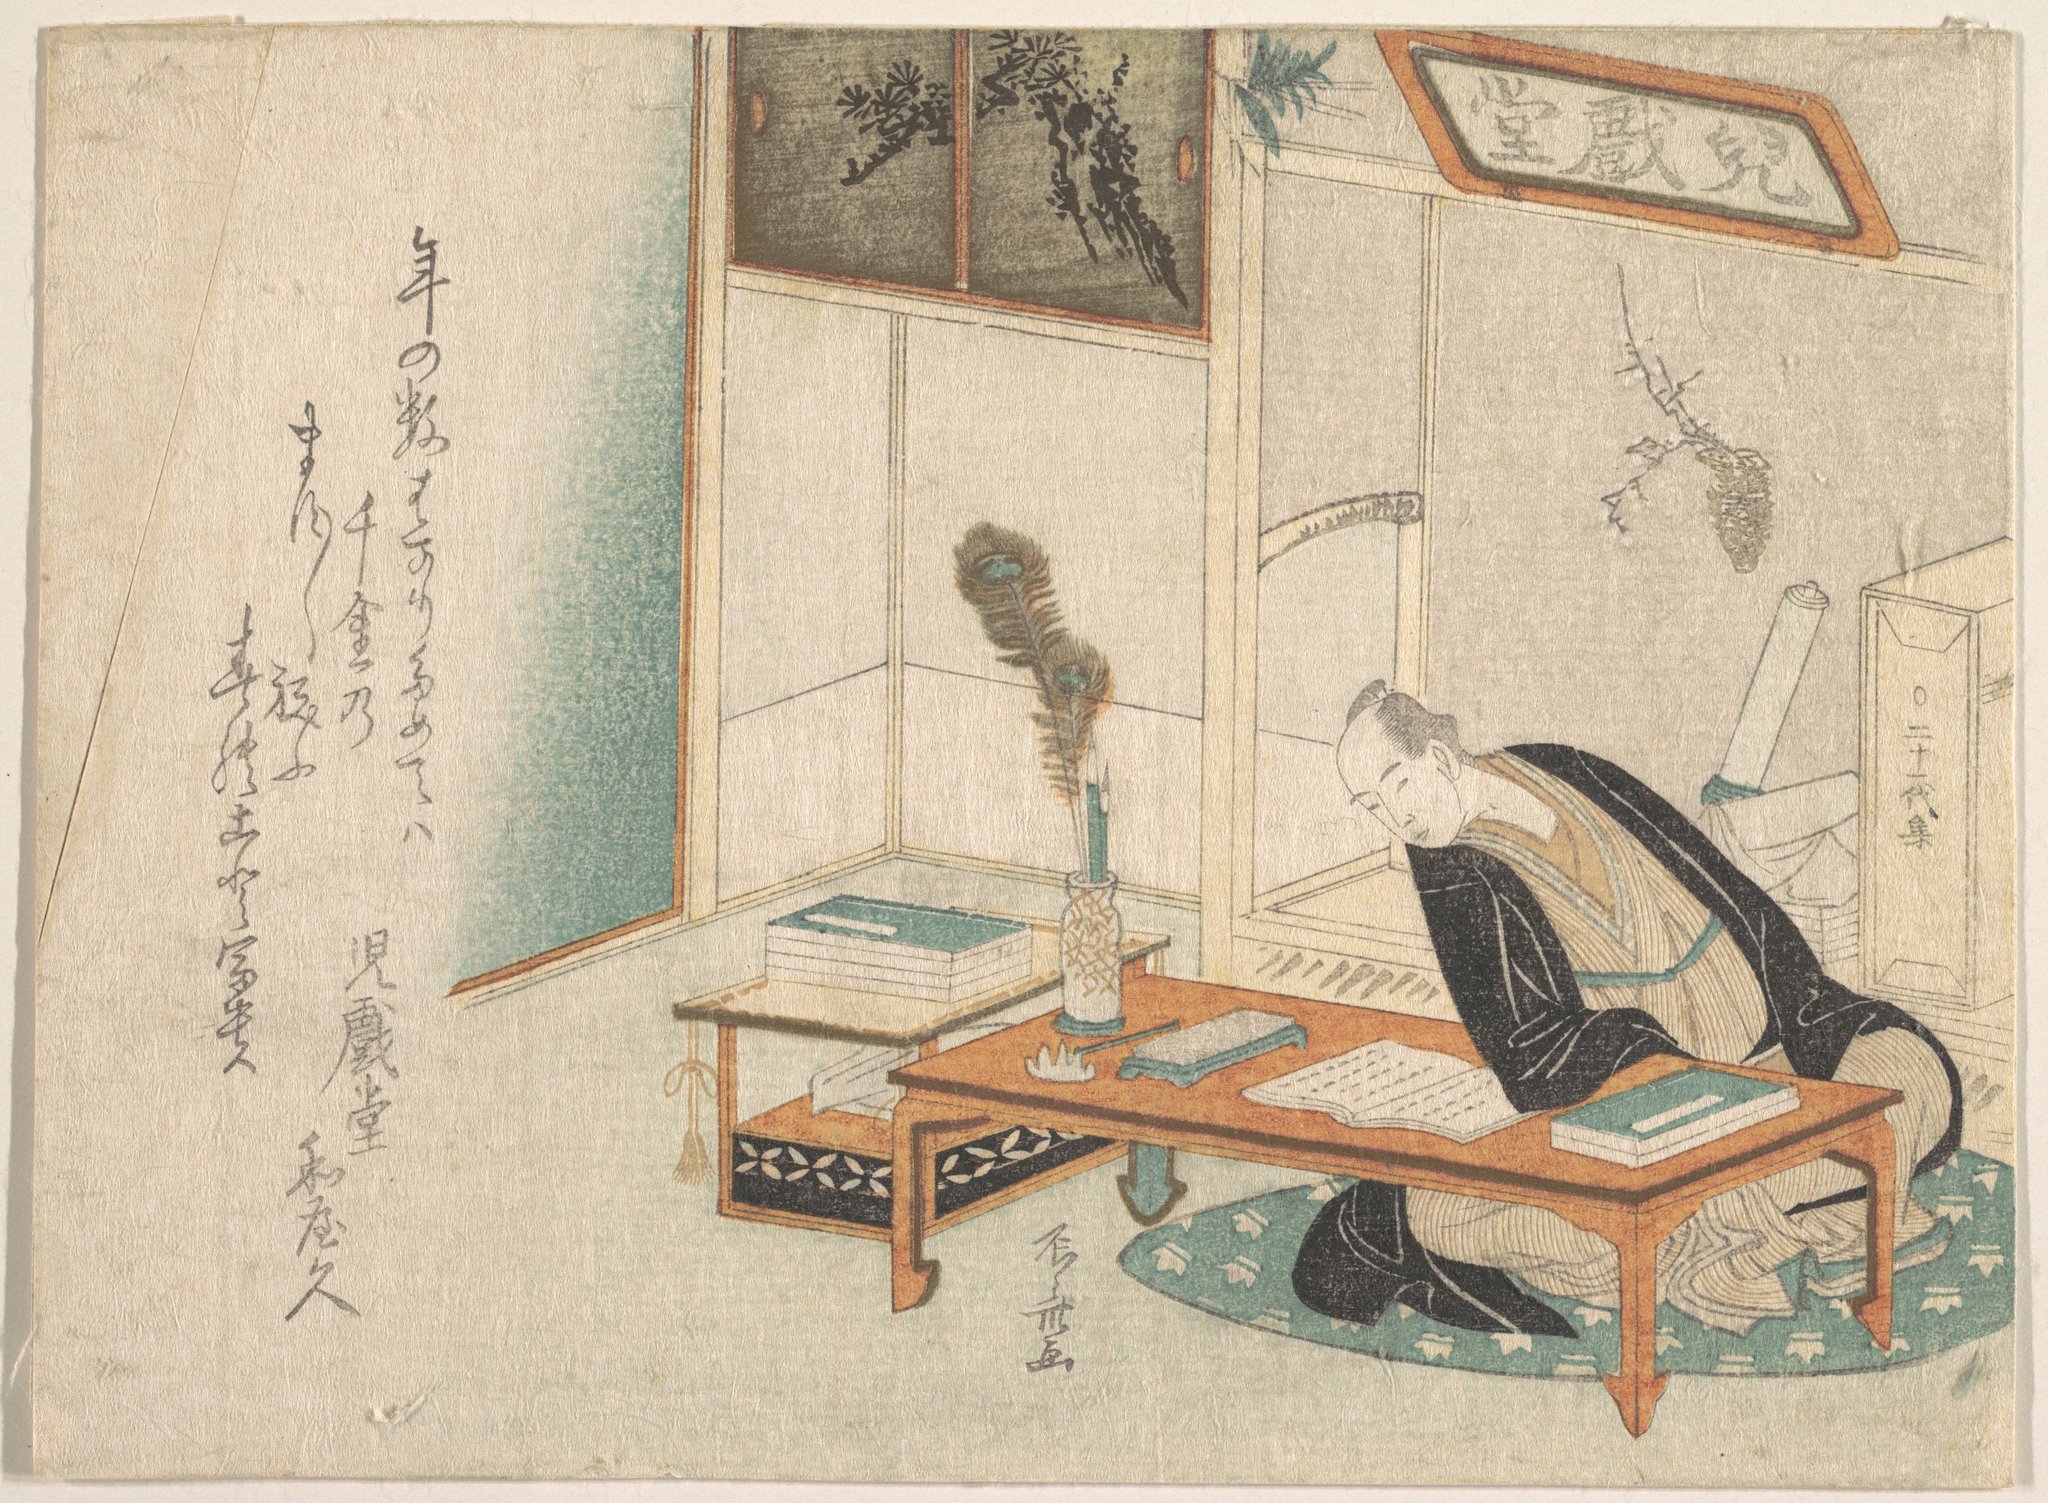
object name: print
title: Man Seated With His Reading and Writing Materials before Him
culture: japanese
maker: ryūryūkyo shinsai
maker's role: artist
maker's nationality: japanese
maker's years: 1799-1823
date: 1750-1835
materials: ink, paper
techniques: surimono, woodblock print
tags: books,men,reading,tables